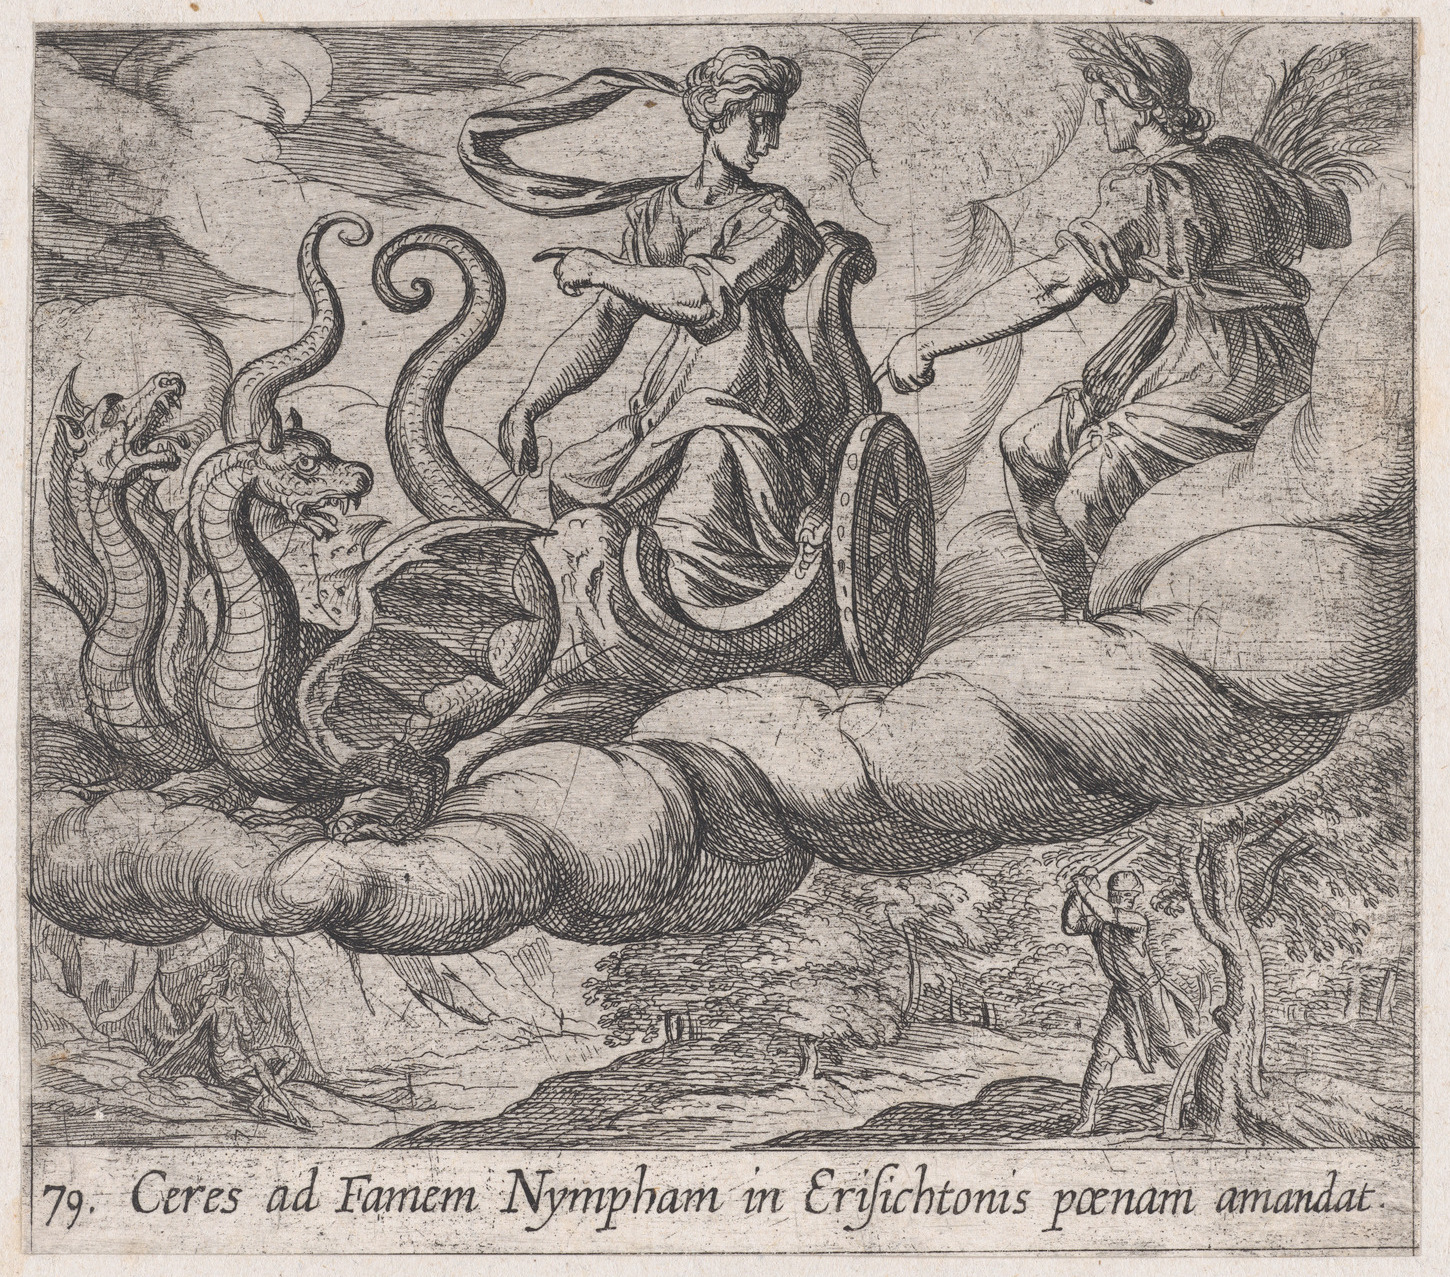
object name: print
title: Plate 79: Ceres Ordering Erysichthon's Punishment (Ceres ad Famem Mypham in Erisichtonis paenam amandat), from Ovid's 'Metamorphoses'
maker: antonio tempesta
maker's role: artist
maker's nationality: italian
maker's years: 1555-1630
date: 1606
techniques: etching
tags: kings,queens,dragons,ceres,punishment